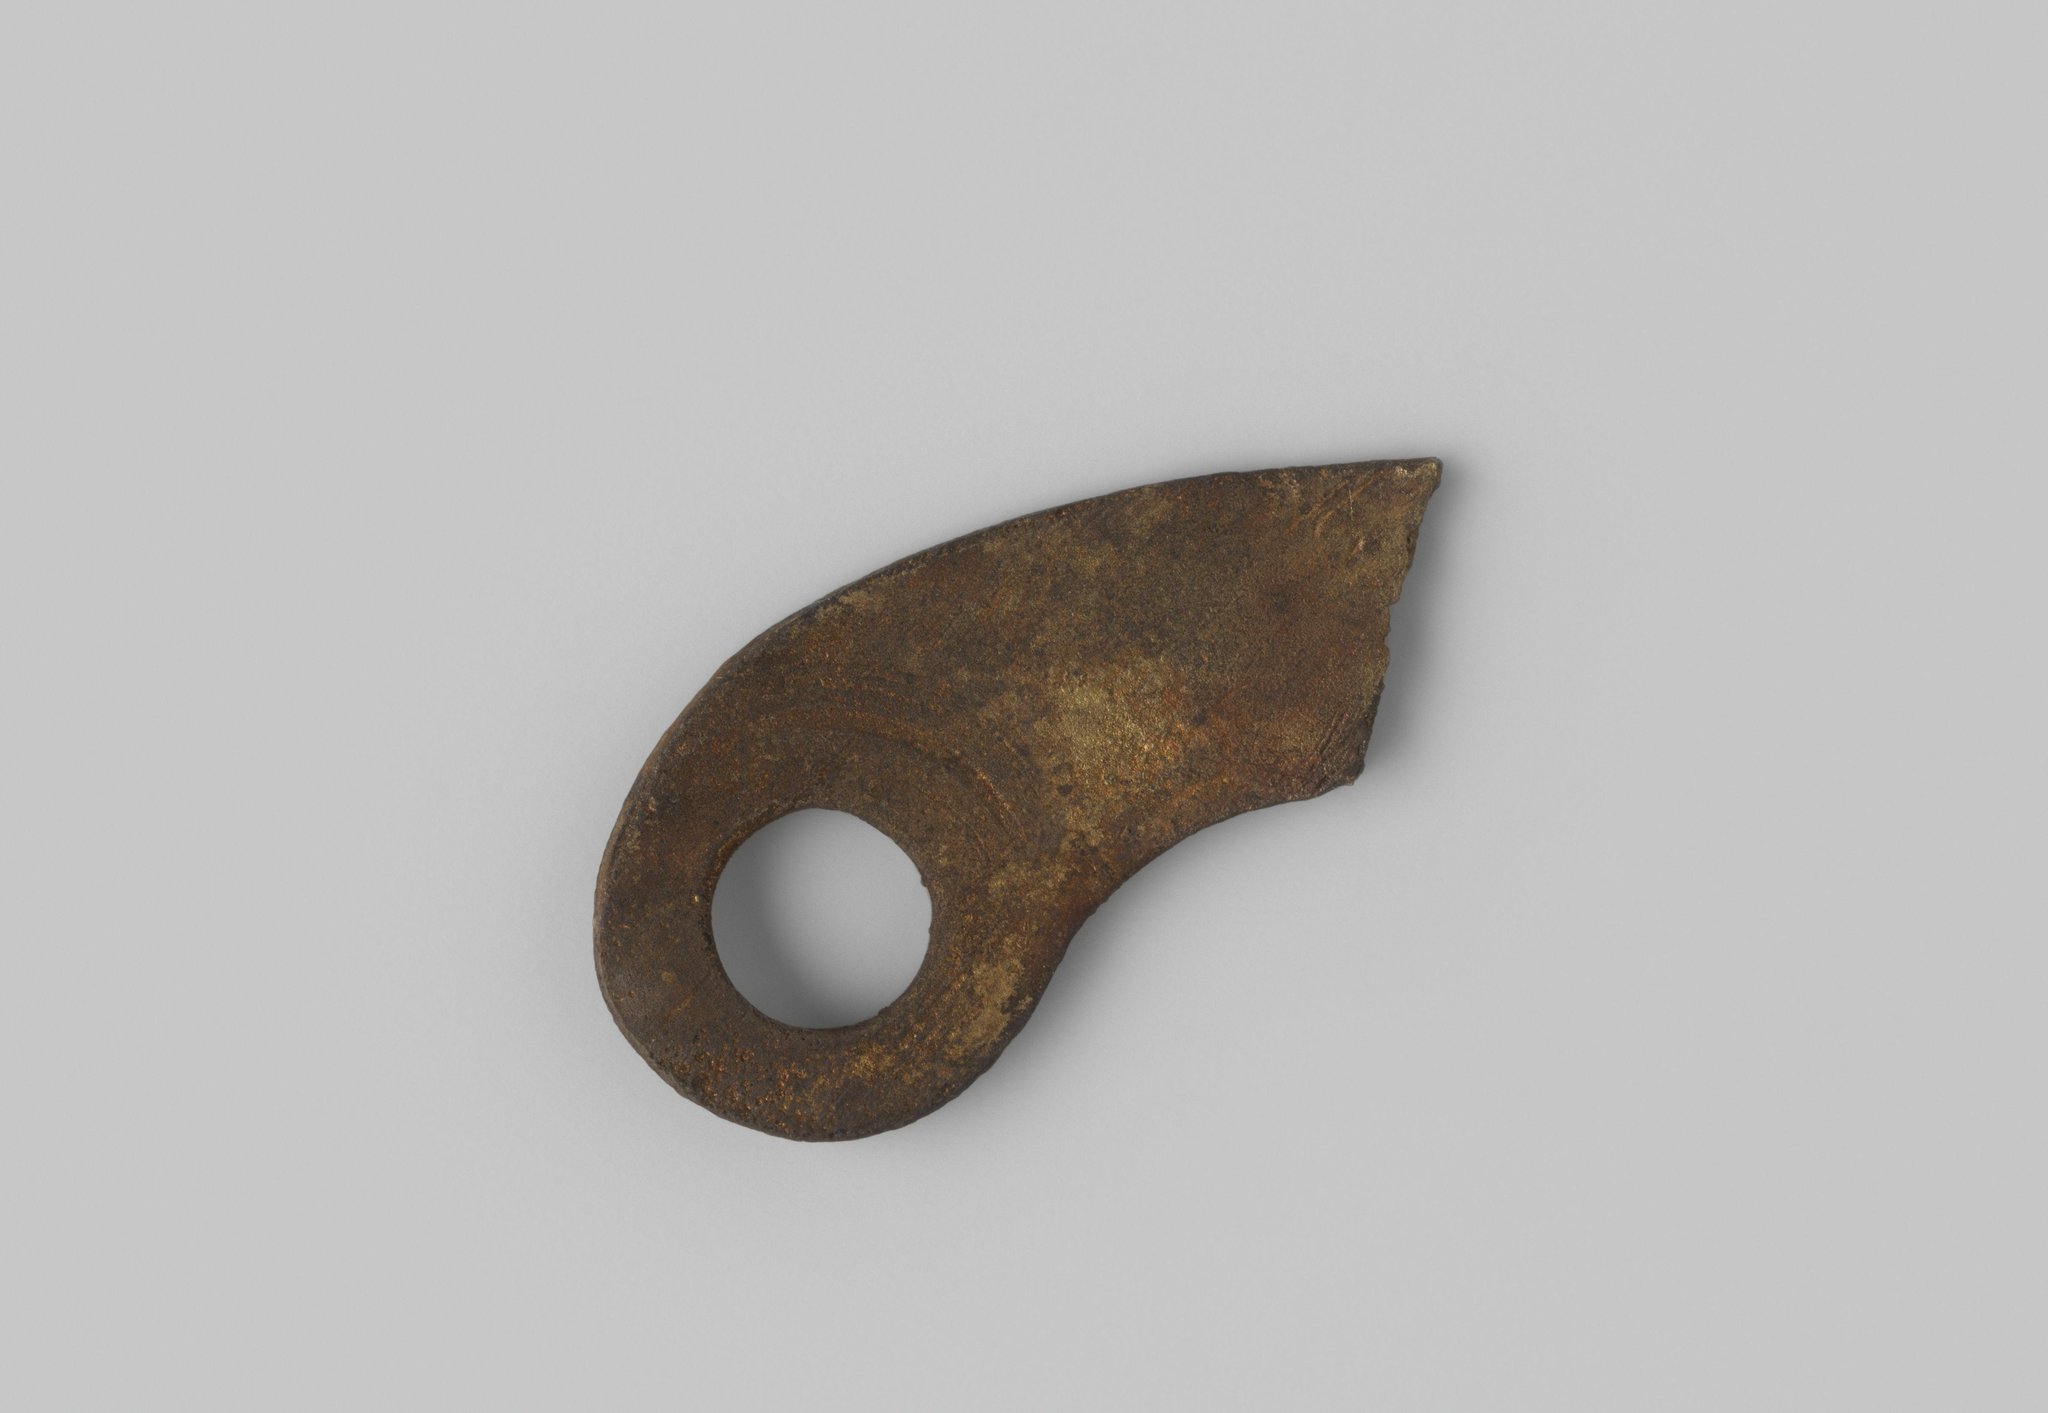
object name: schroefplaat, schroefblik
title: Fragment schroefplaat van een musket uit het wrak van de Oost-Indiëvaarder Hollandia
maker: Anonymous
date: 1700-1743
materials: copper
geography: netherlands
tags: verenigde oostindische compagnie, hollandia (schip), annet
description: Fragm, eye, id. NG 1978-74H986 or NG 1980-27H3069, side plate.